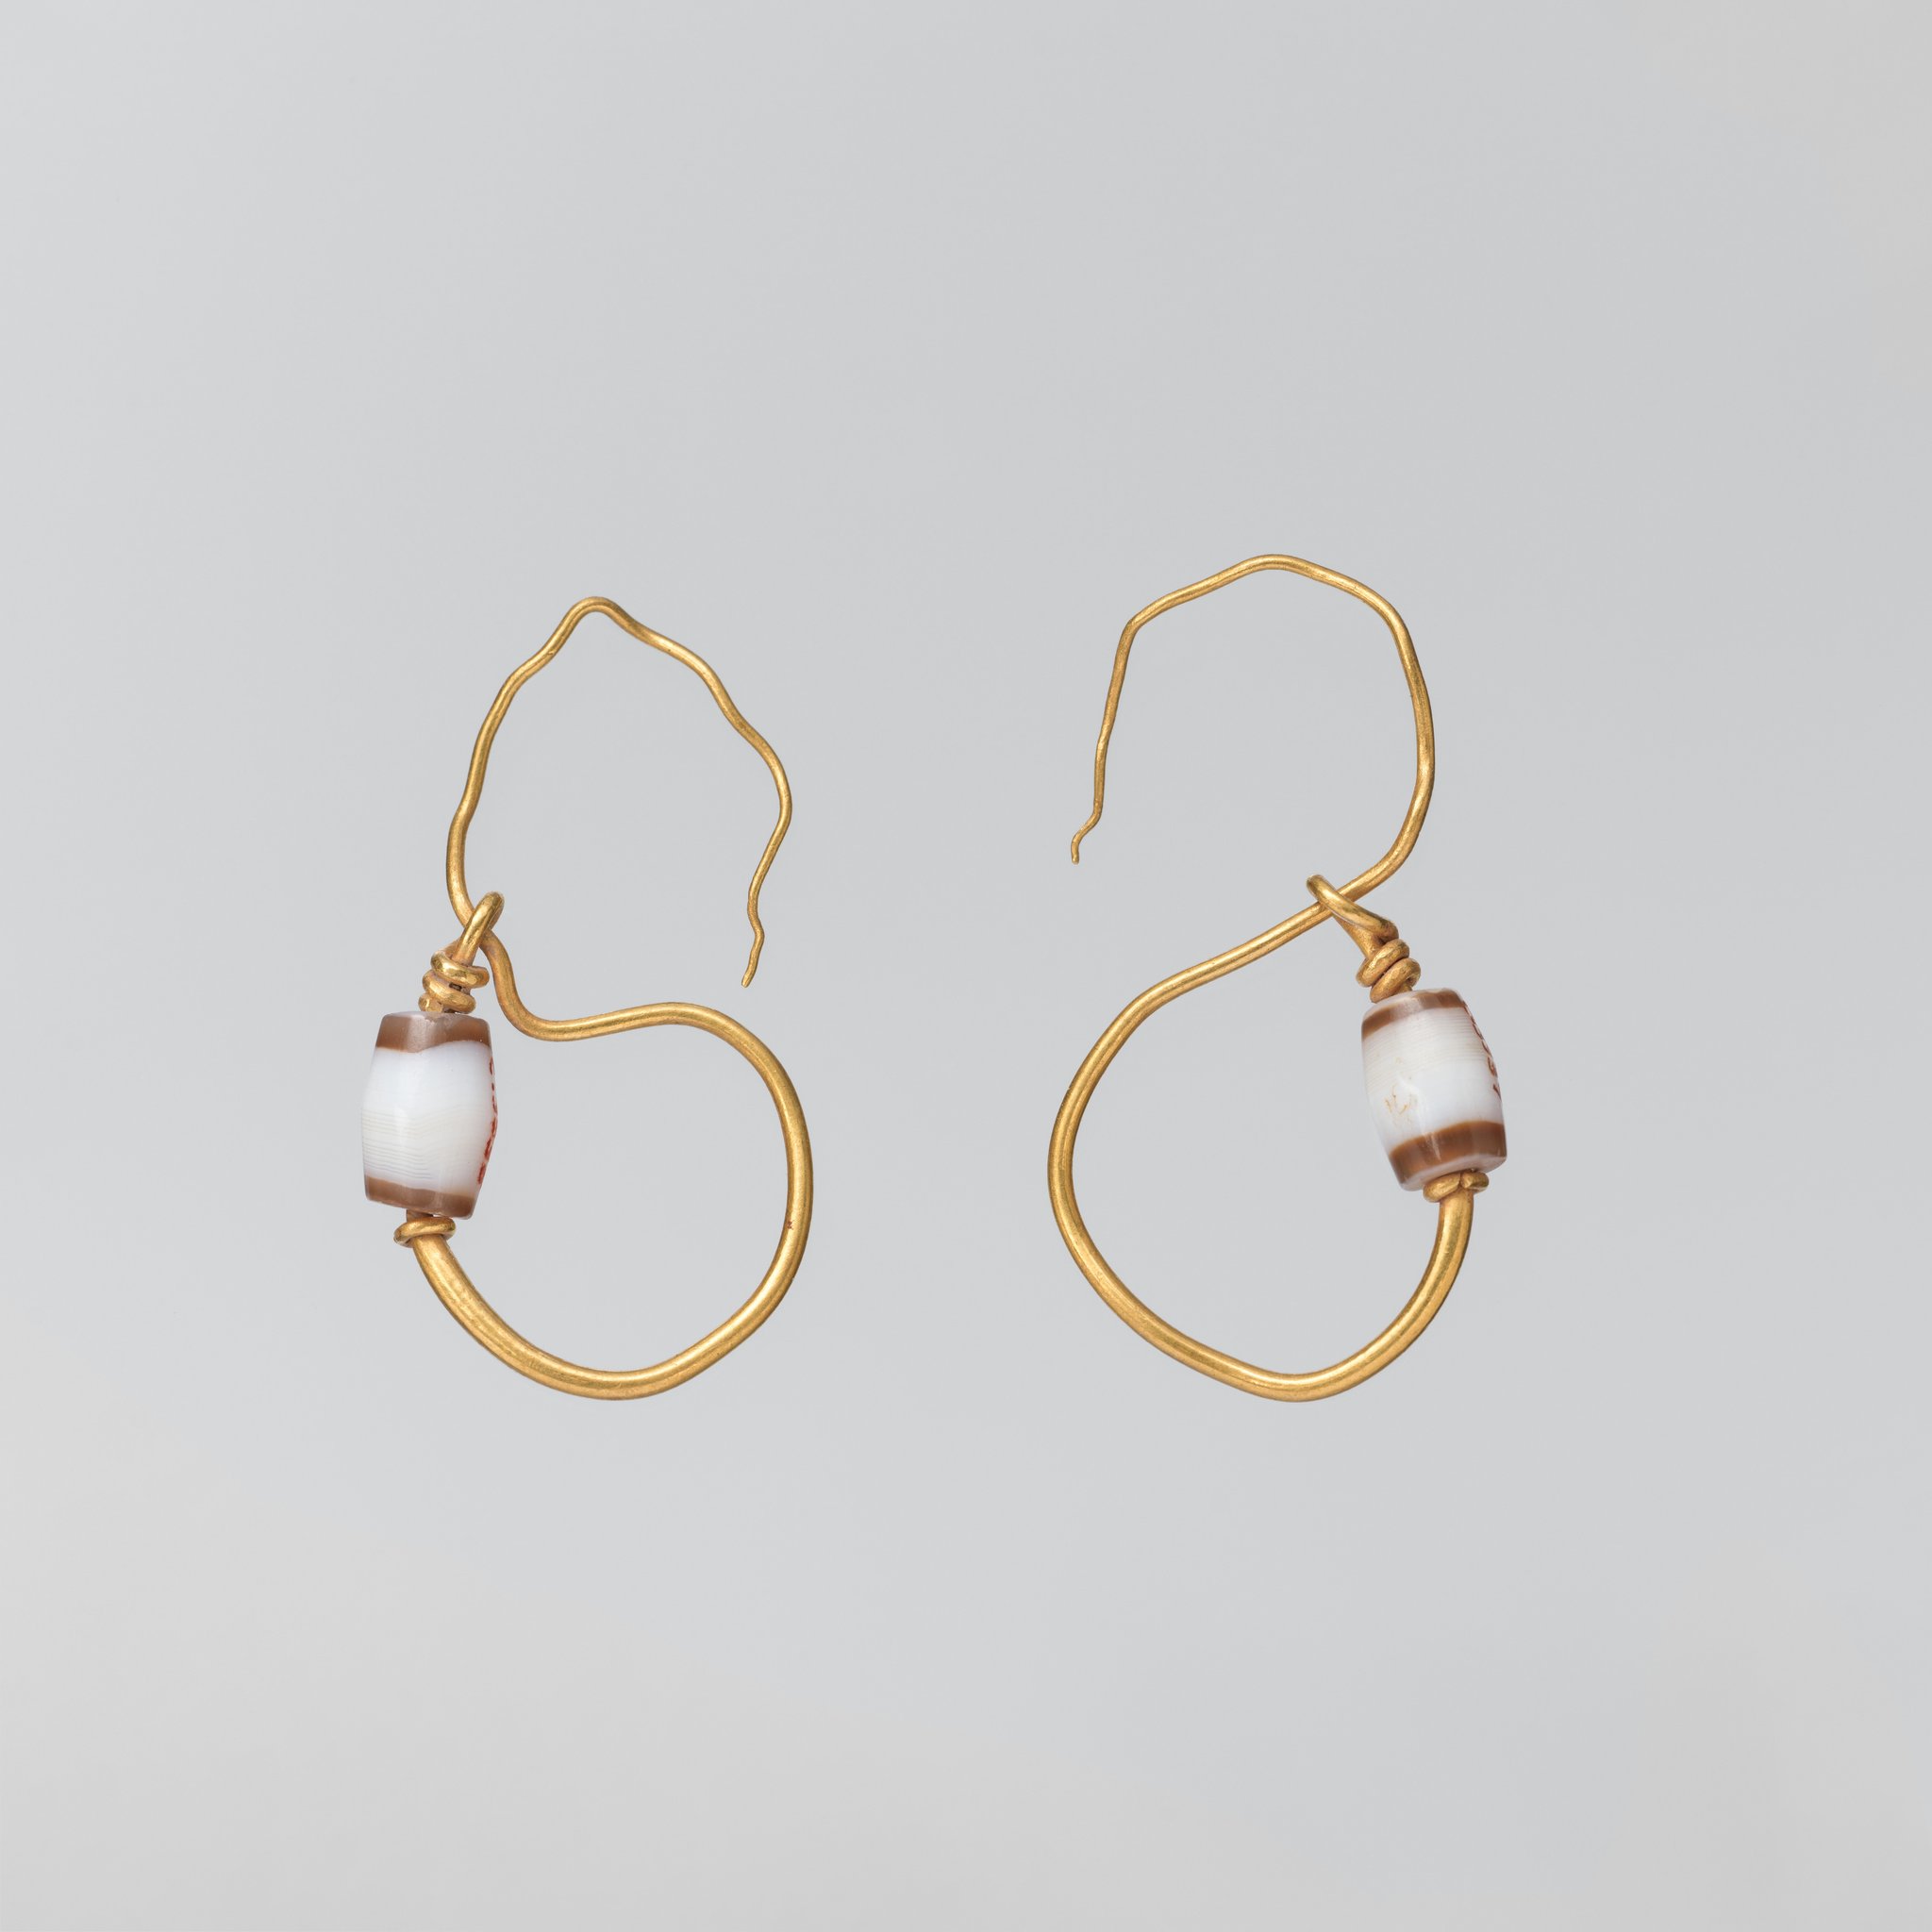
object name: earring, delta shaped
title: Gold and banded agate earring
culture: roman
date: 101-200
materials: stone, gold